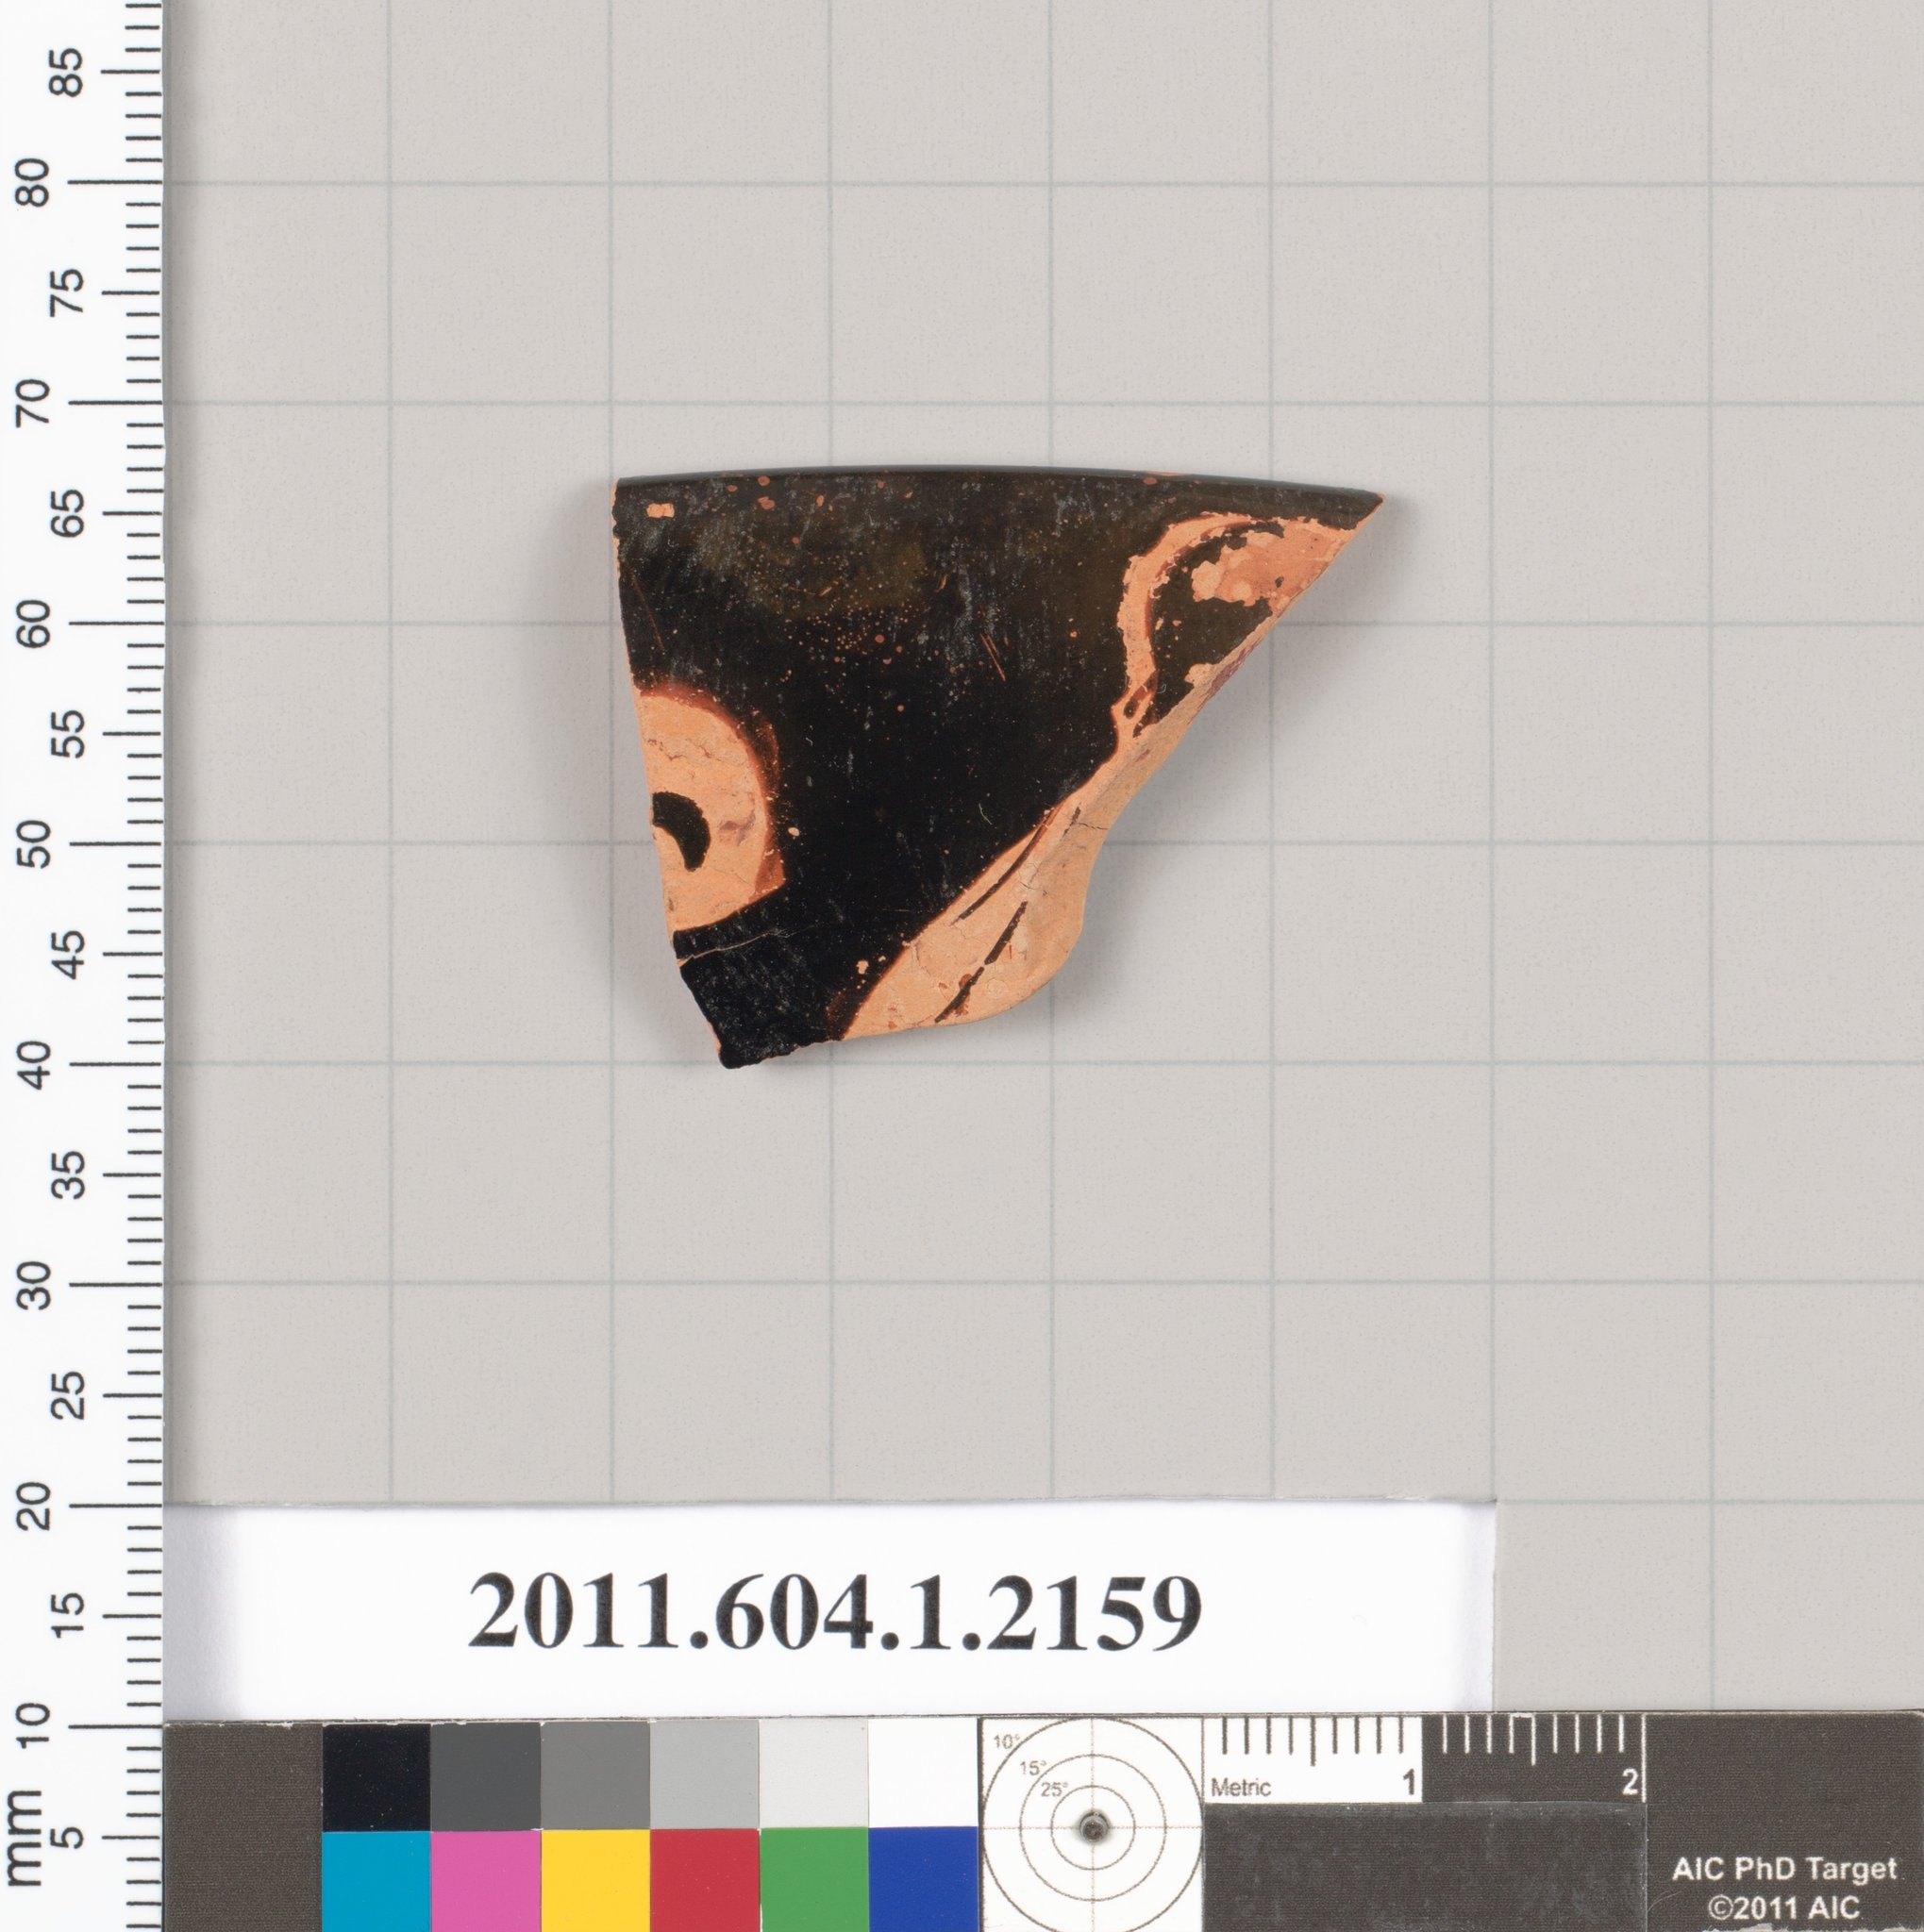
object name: kylix fragment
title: Terracotta rim fragment of a kylix (drinking cup)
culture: greek, attic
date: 467-435 BCE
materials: terracotta